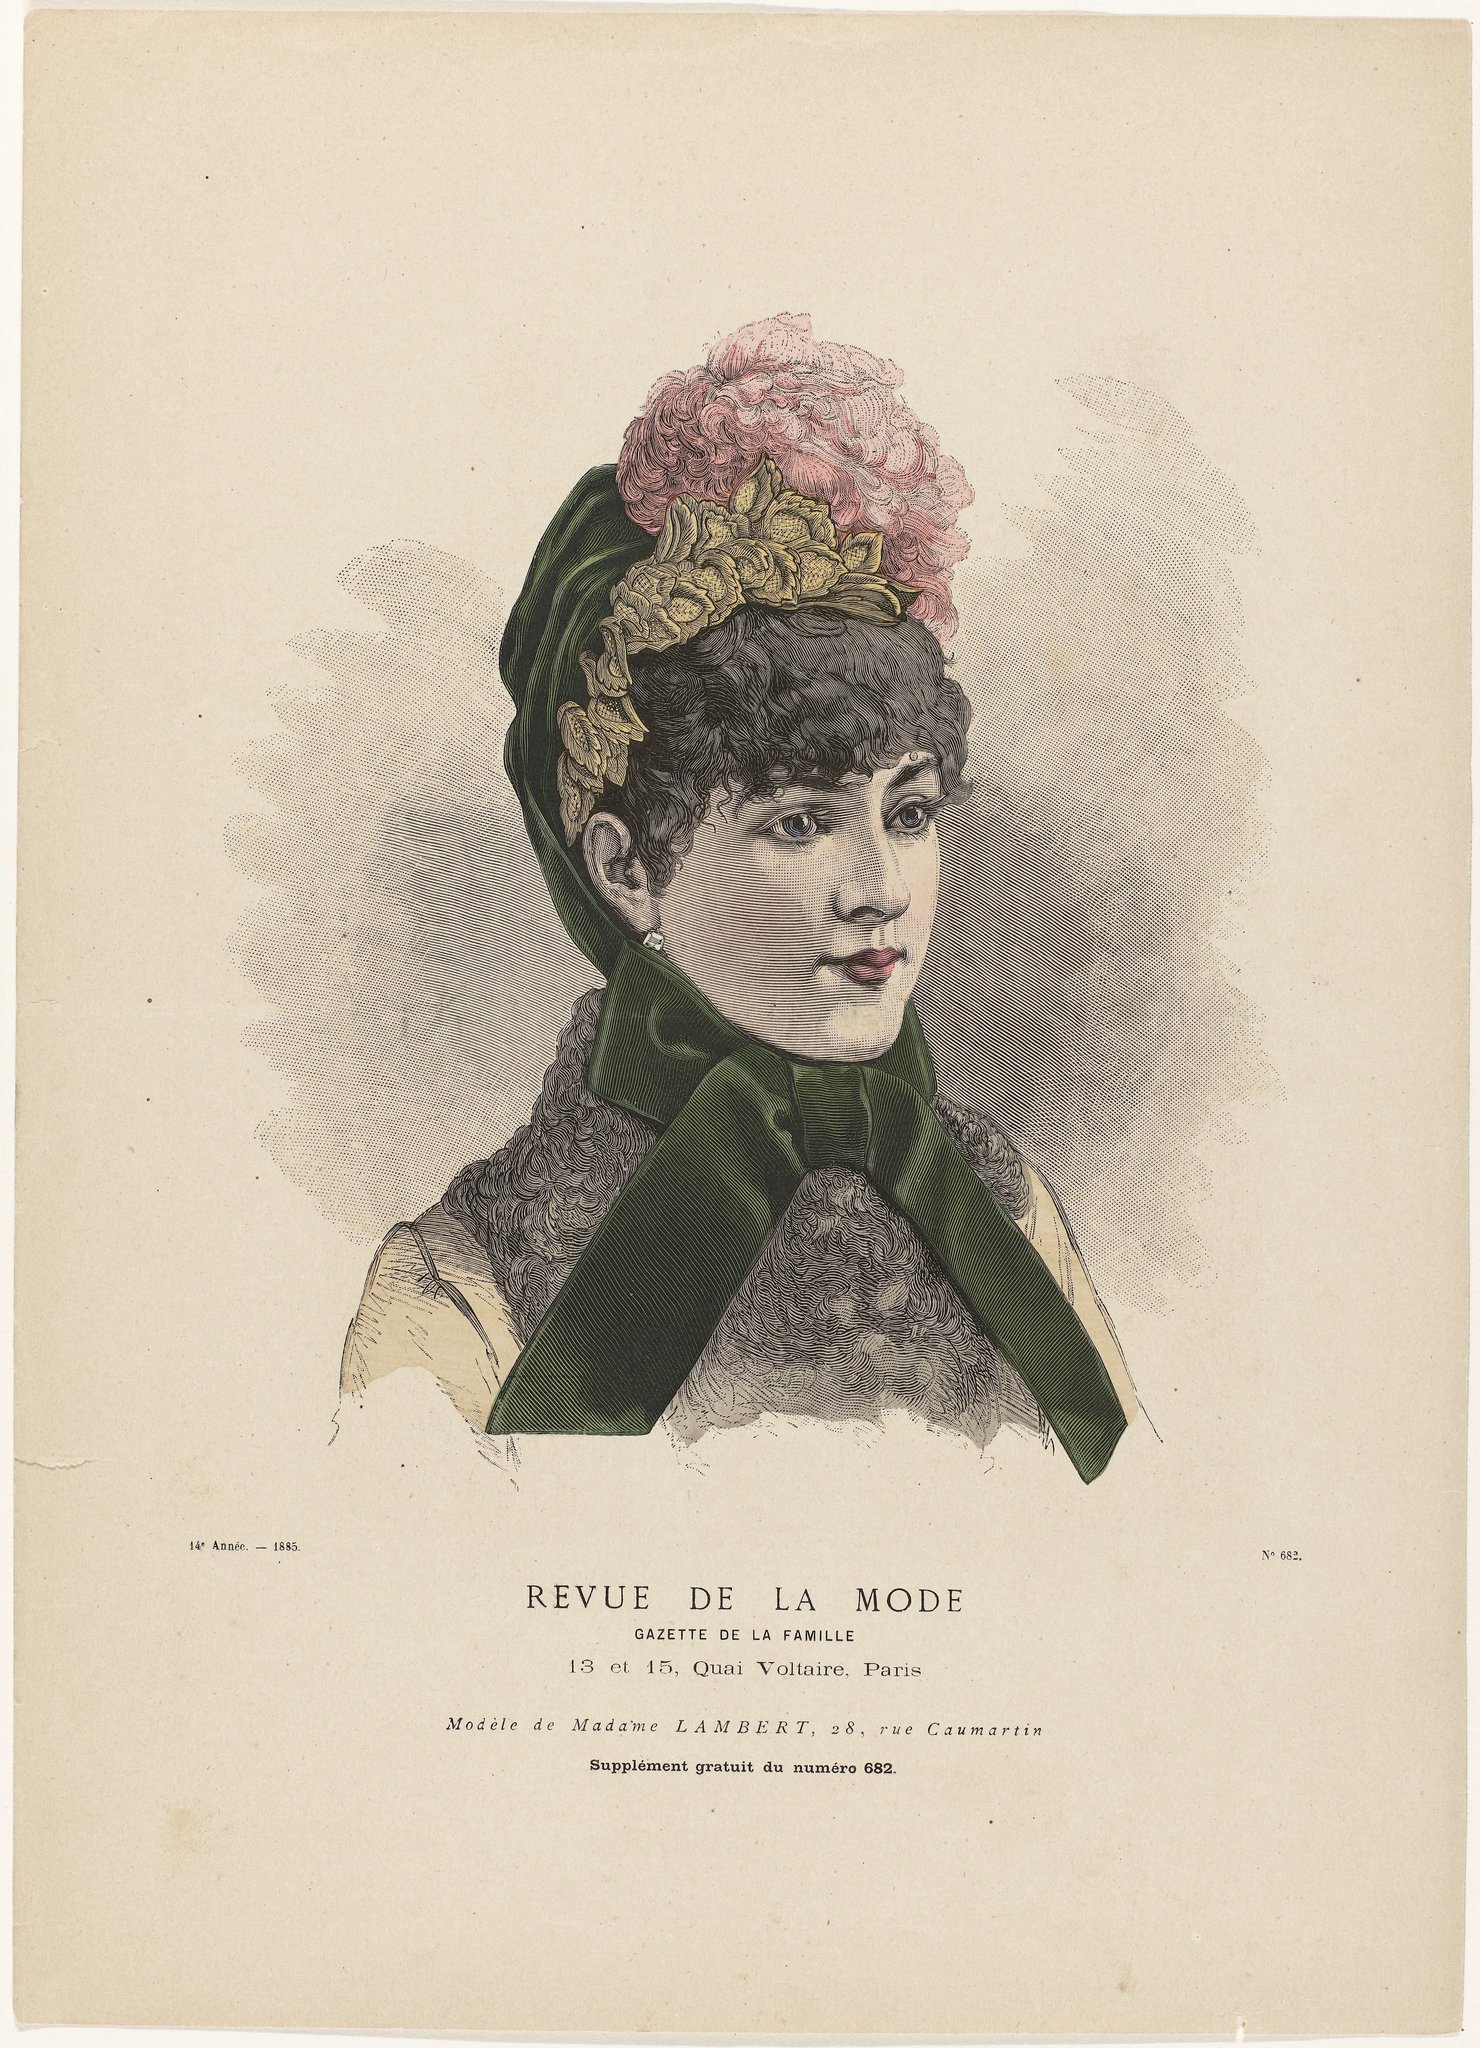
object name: fashion print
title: Revue de la Mode, Gazette de la Famille, dimanche 25 janvier 1885, 14e Année, supplément No. 682: Modèle de Madame LAMBERT (...)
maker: Anonymous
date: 1885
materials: paper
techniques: hand coloring, engraving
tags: head-gear (capote) (+ women's clothes), fashion plates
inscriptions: address: ‘13 et 15, Quai Voltaire, Paris’, title: ‘REVUE DE LA MODE / GAZETTE DE LA FAMILLE’, caption: ‘Modèle de Madame LAMBERT, 28, rue Caumartin / Supplément gratuit du numéro 682.’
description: 'Capote de visites' van mosgroen fluweel. Volgens het onderschrift: model van Madame (Marie) Lambert. Prent uit het modetijdschrift Revue de la Mode (1872-1913). Uitgebreide beschrijving van de kleding op pagina 29 "PLANCHE DE CHAPEAU COLORIÉ".